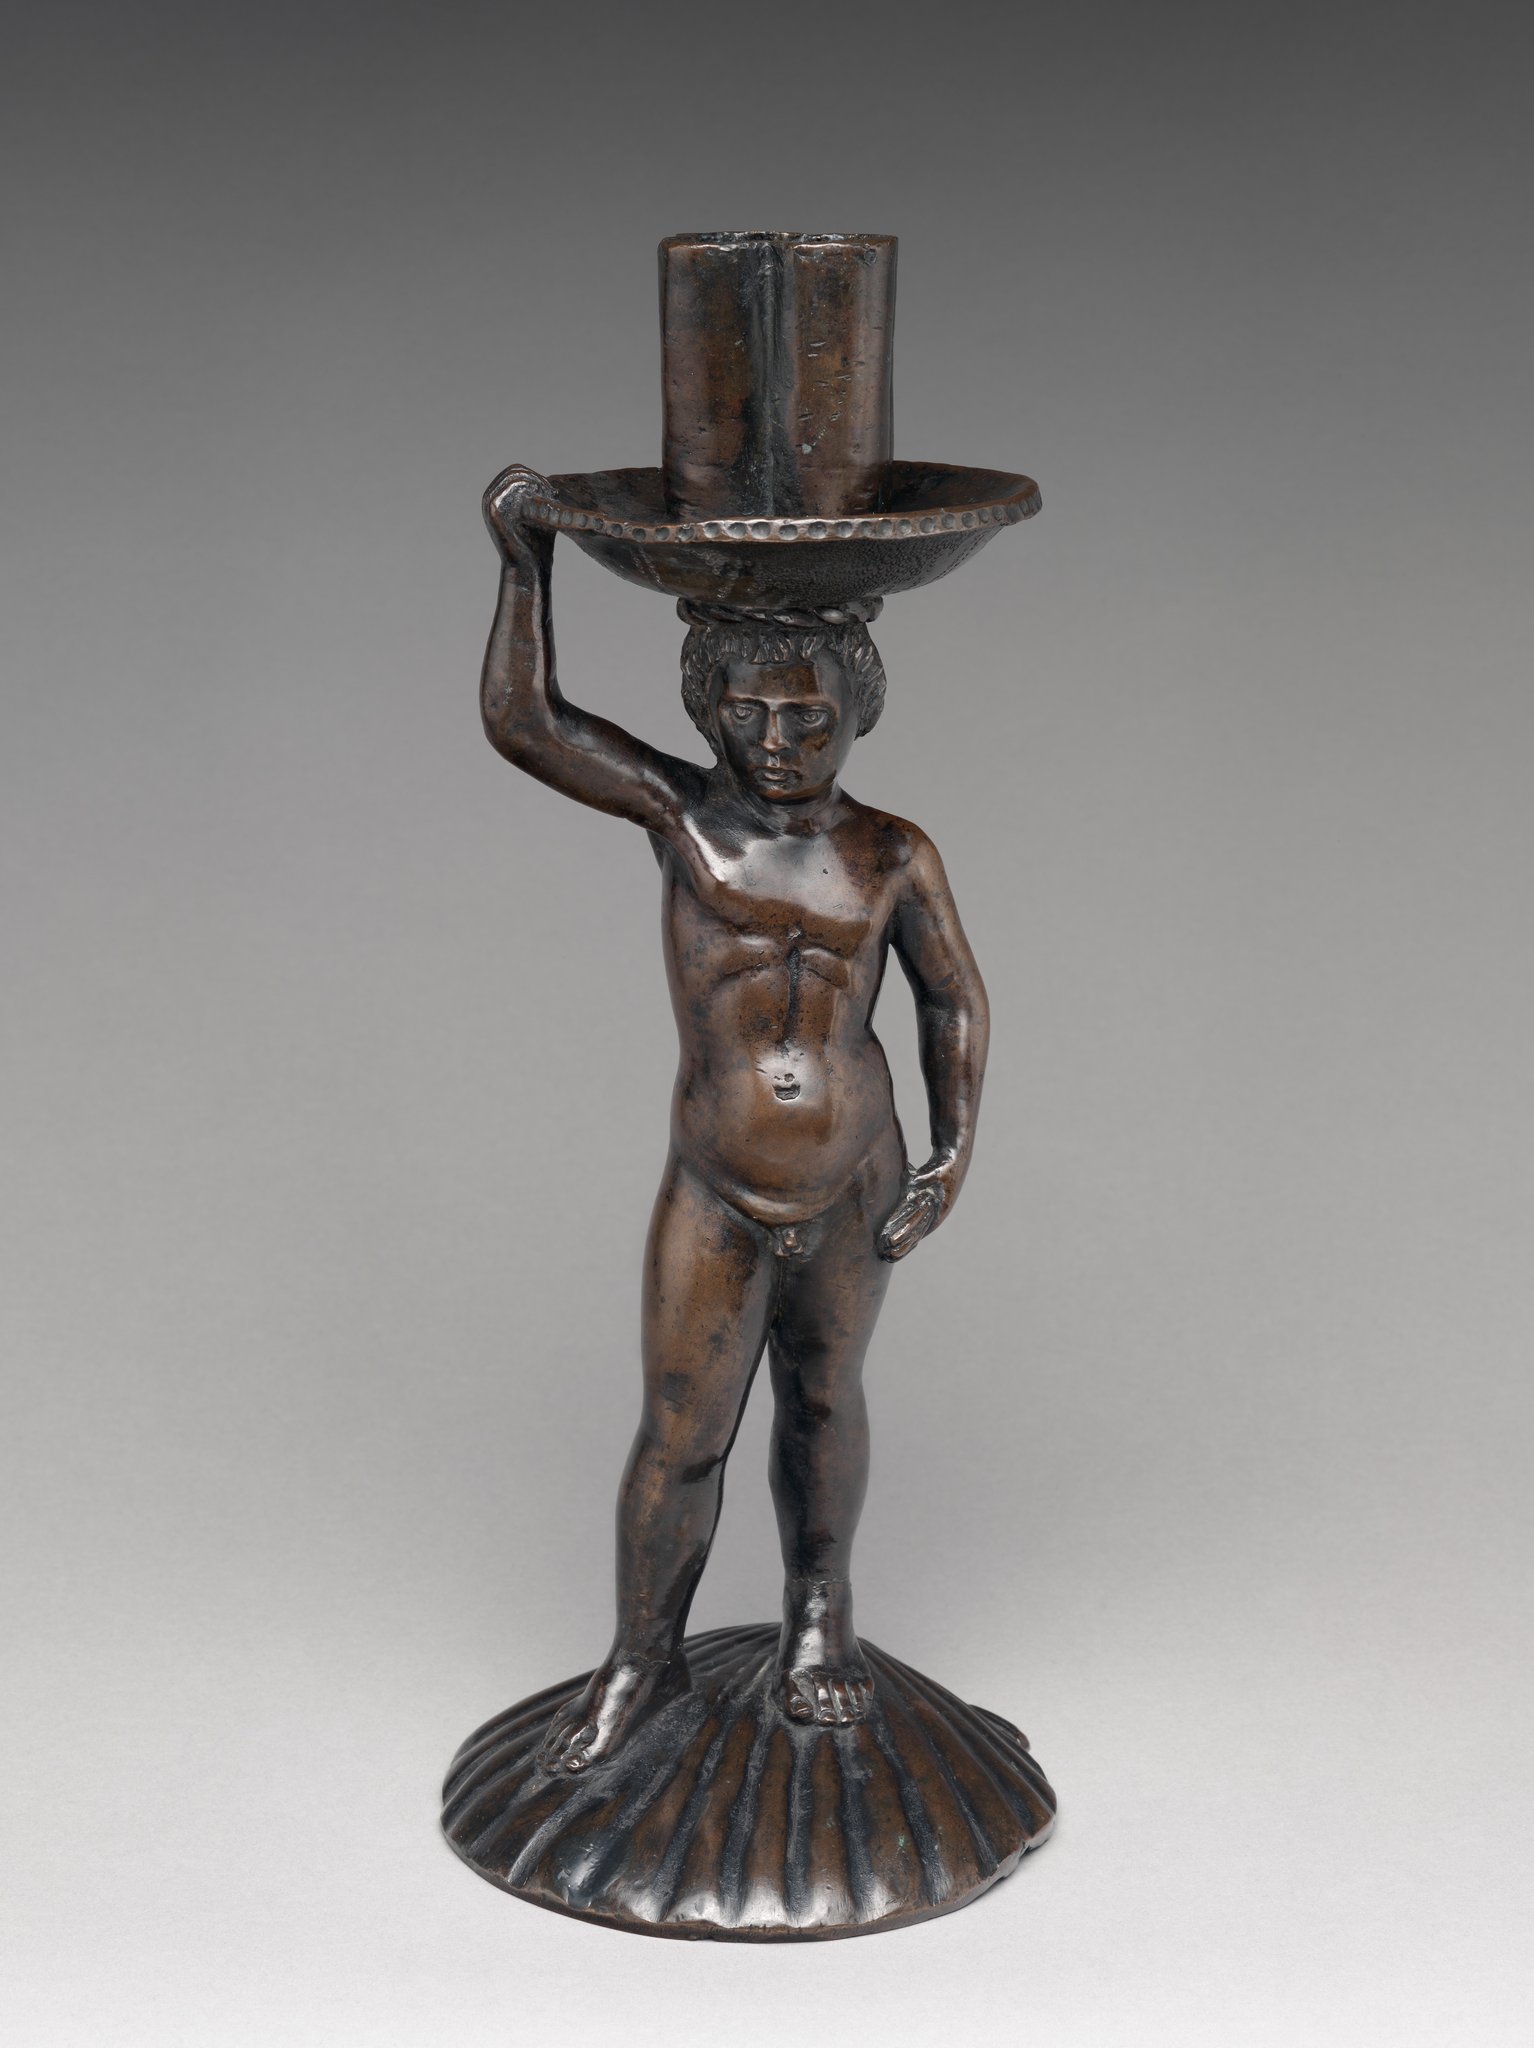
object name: candlestick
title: Boy on a shell, holding a candlestick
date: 1434-1466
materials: bronze, gilt, oil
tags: boys,shells